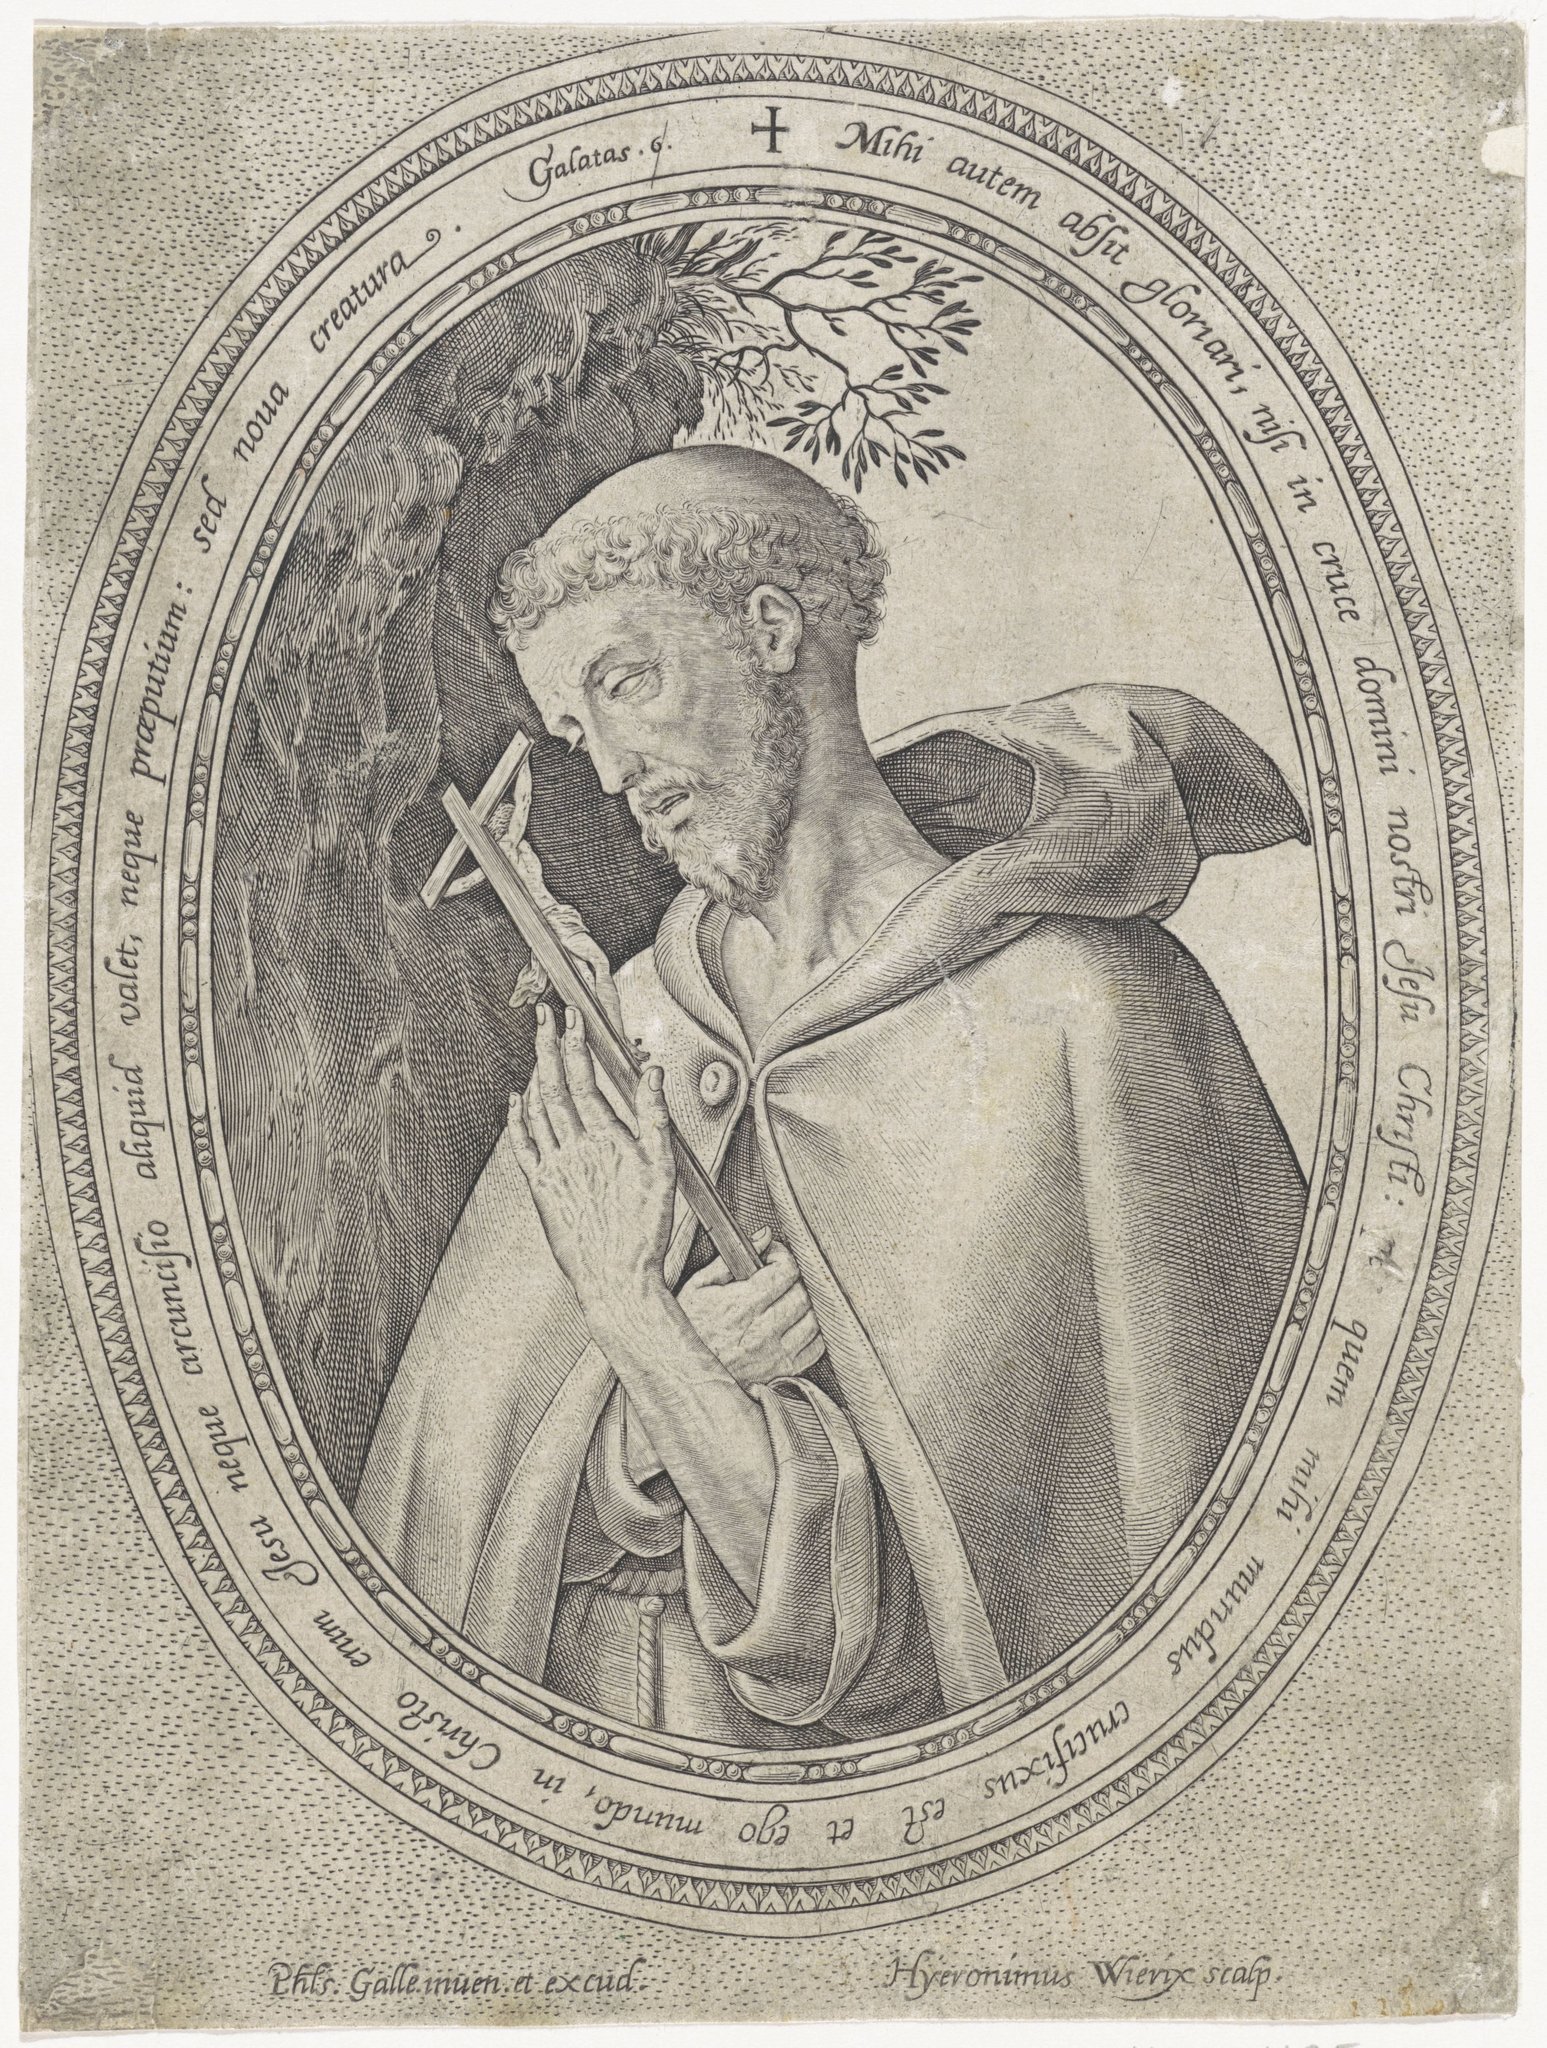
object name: print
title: H. Franciscus van Assisi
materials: paper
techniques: engraving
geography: antwerp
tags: founder of the order of friars minor (franciscans), francis(cus) of assisi; possible attributes: book, crucifix, lily, skull, stigmata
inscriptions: collector's mark: Lugt 2228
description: De heilige Franciscus van Assisi, in habijt, bij een rots. In zijn handen houdt hij een crucifix. De voorstelling is gevat in een ovale omlijsting waarin een Bijbelcitaat uit Gal. 6 in het Latijn.